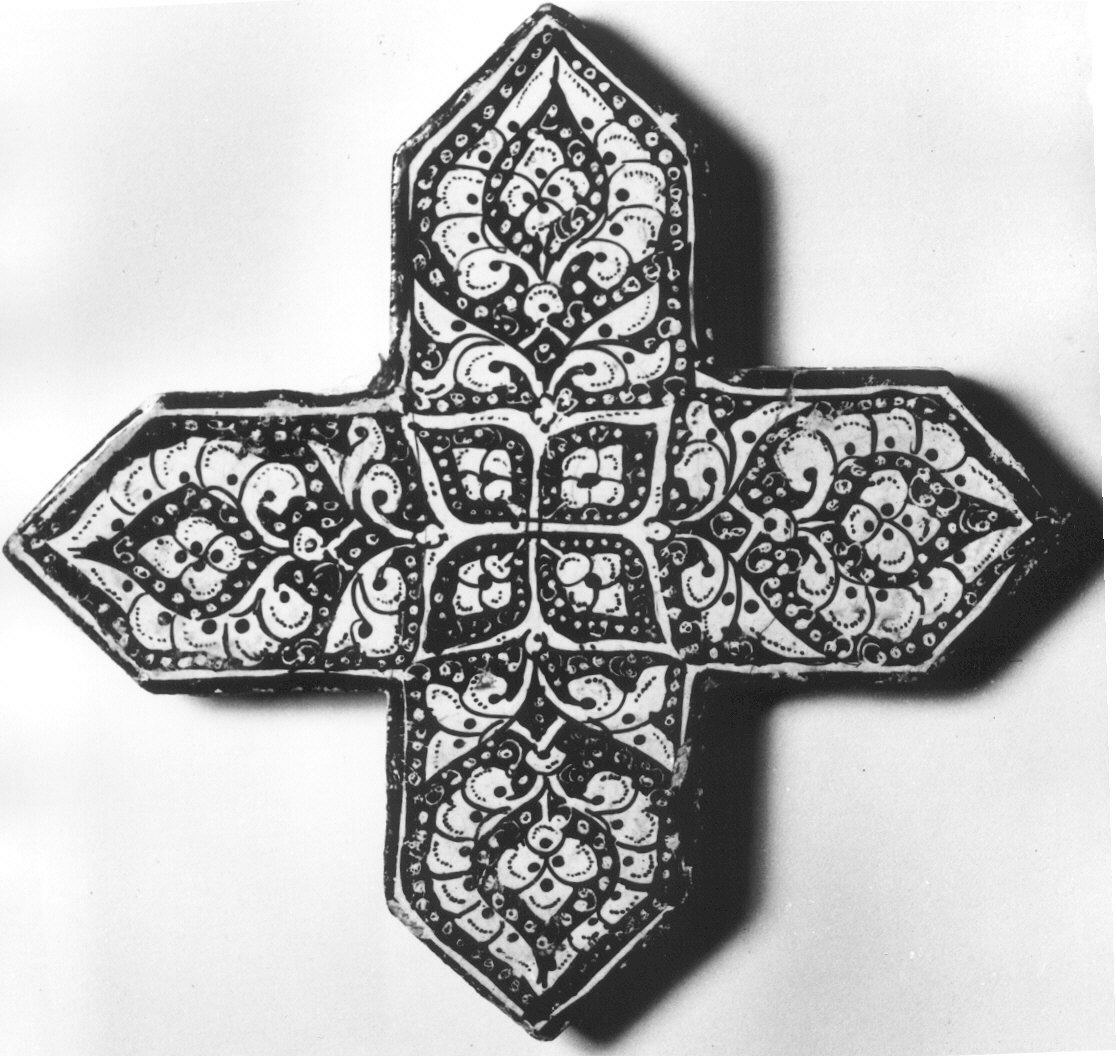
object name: cross shaped tile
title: Cross-Shaped Tile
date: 1201-1300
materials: glaze, stonepaste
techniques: luster painting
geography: iran